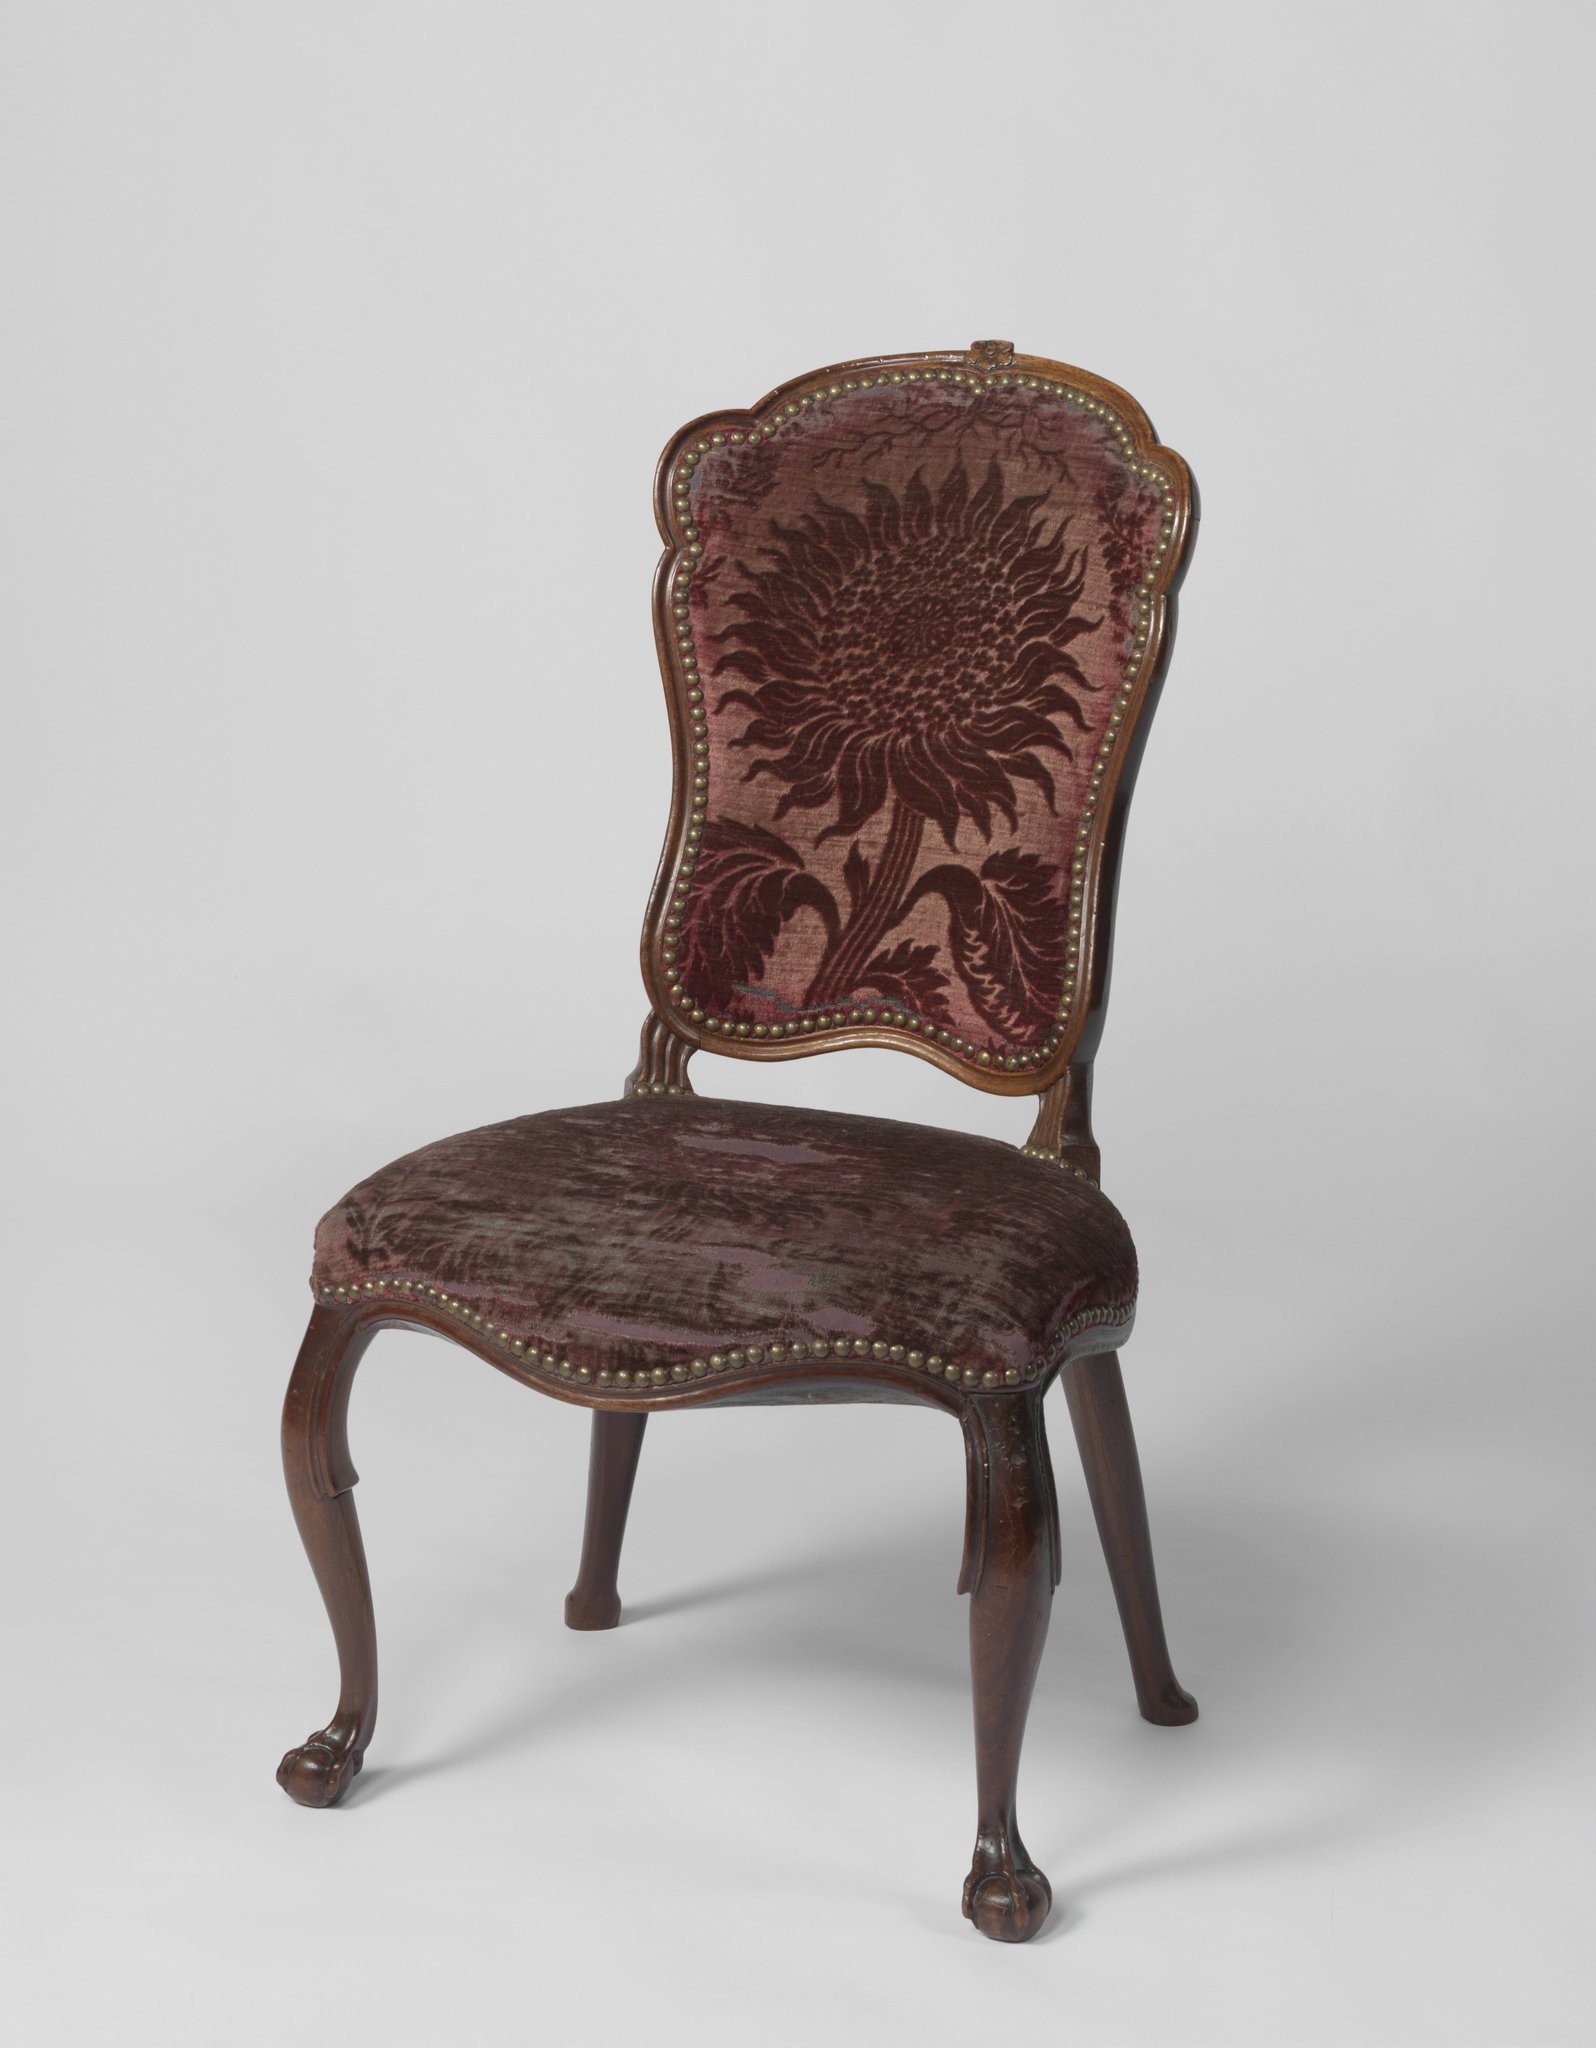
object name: seating furniture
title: Chair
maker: Anonymous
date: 1760-1775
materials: wood, velvet, wool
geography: netherlands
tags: flowers: sunflower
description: This chair combines influences from England and France into a typically Dutch product. The inspiration for the hollow (curved) back, for example, is French, while the use of mahogany is English. The upholstery of moquette (mock velvet) was made in the Netherlands.